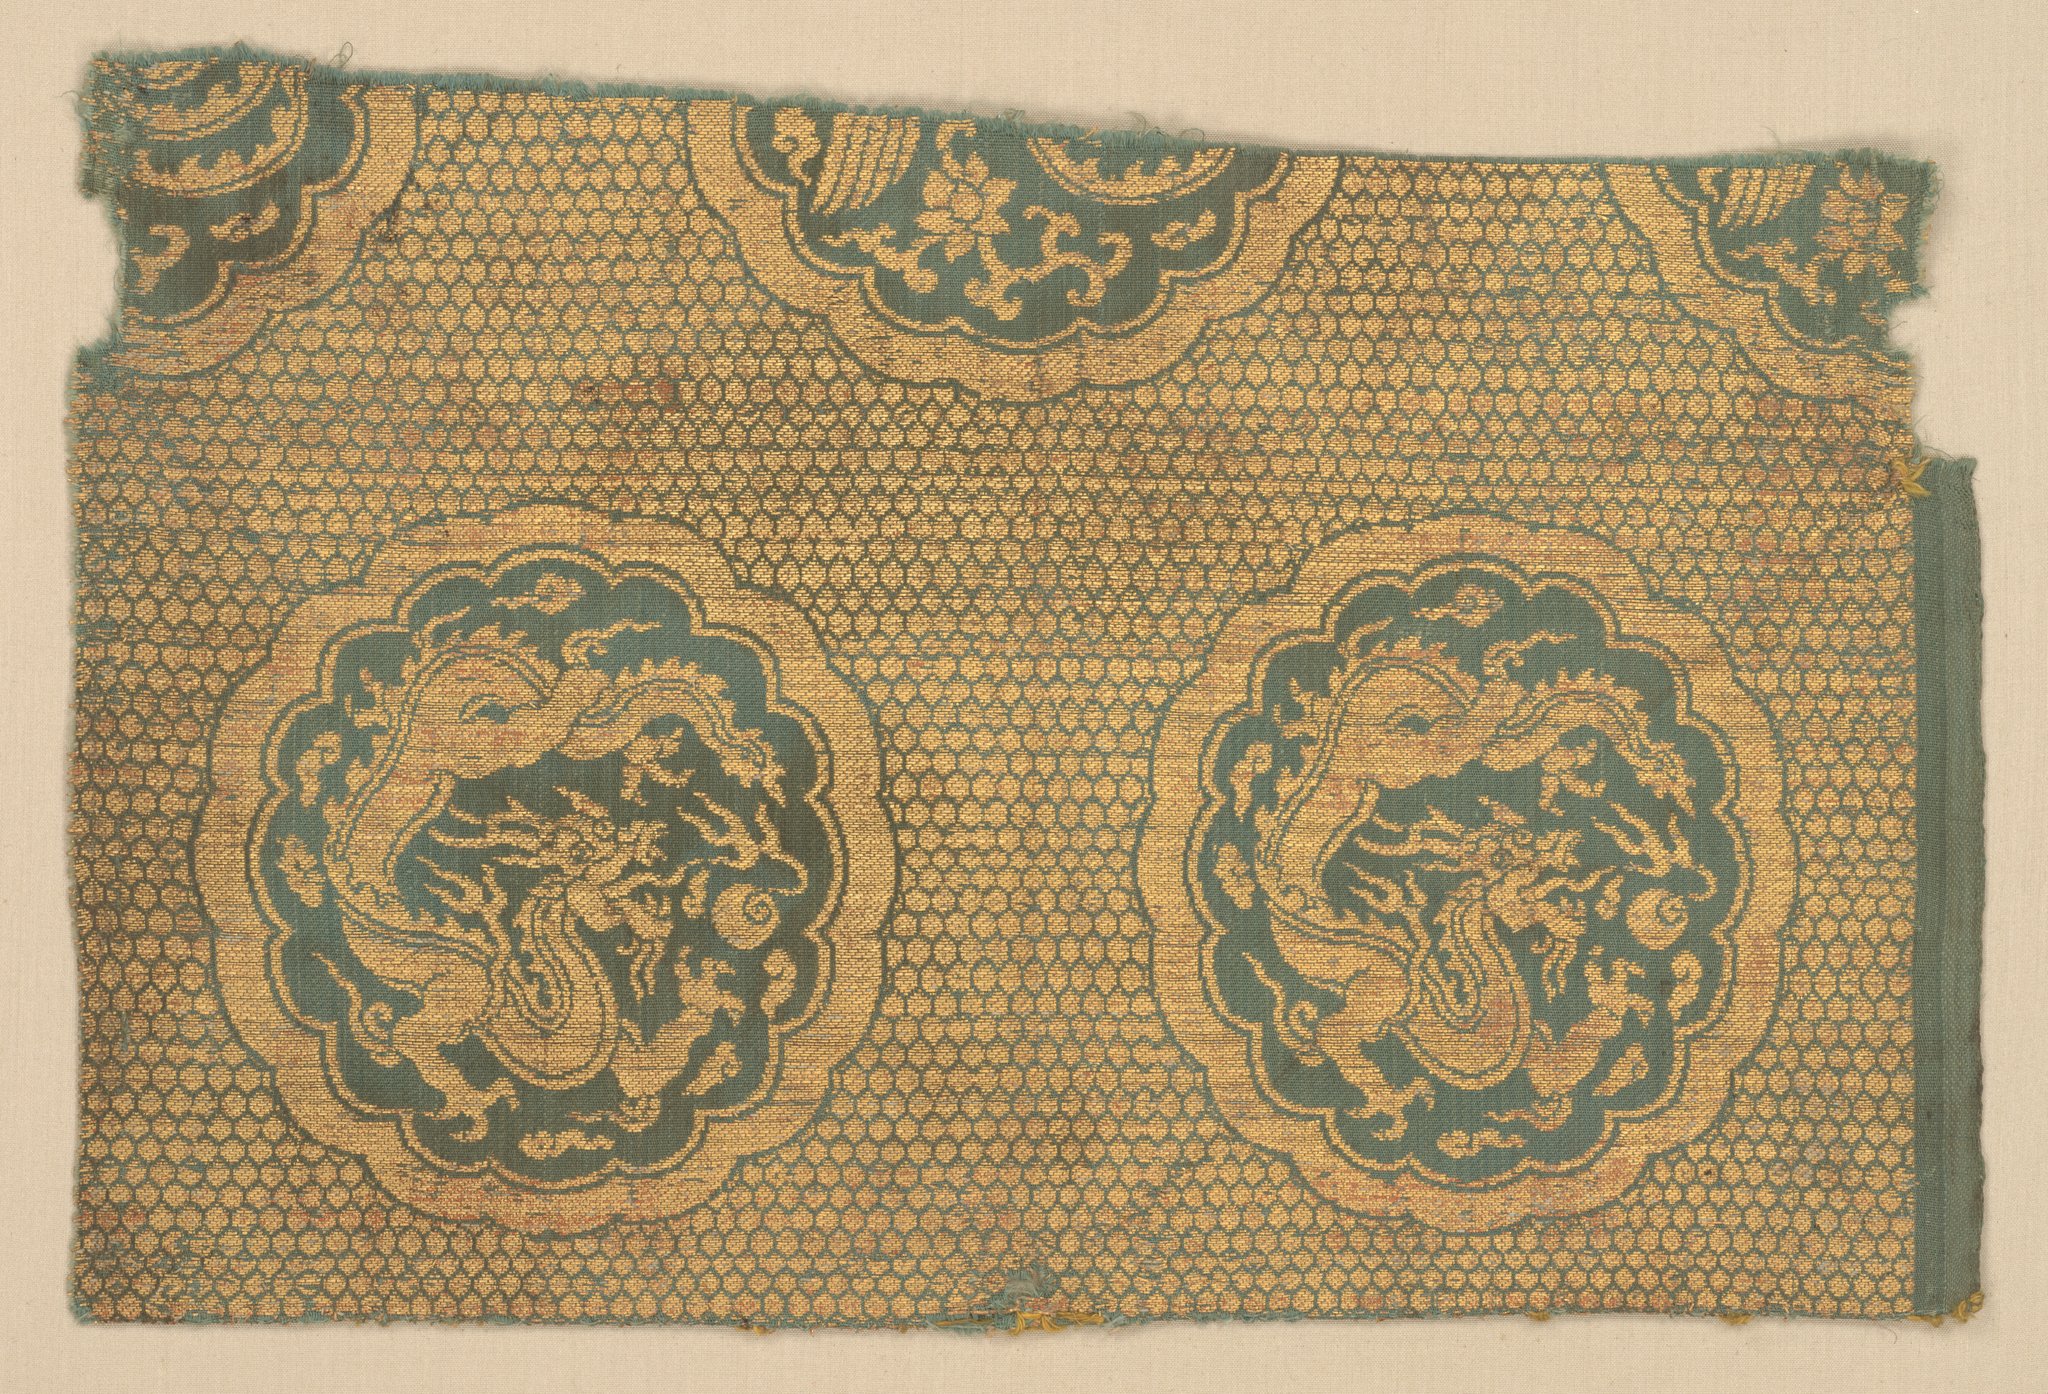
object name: textile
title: Textile with dragons and phoenixes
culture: chinese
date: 1267-1400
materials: metal thread, silk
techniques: lampas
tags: dragons